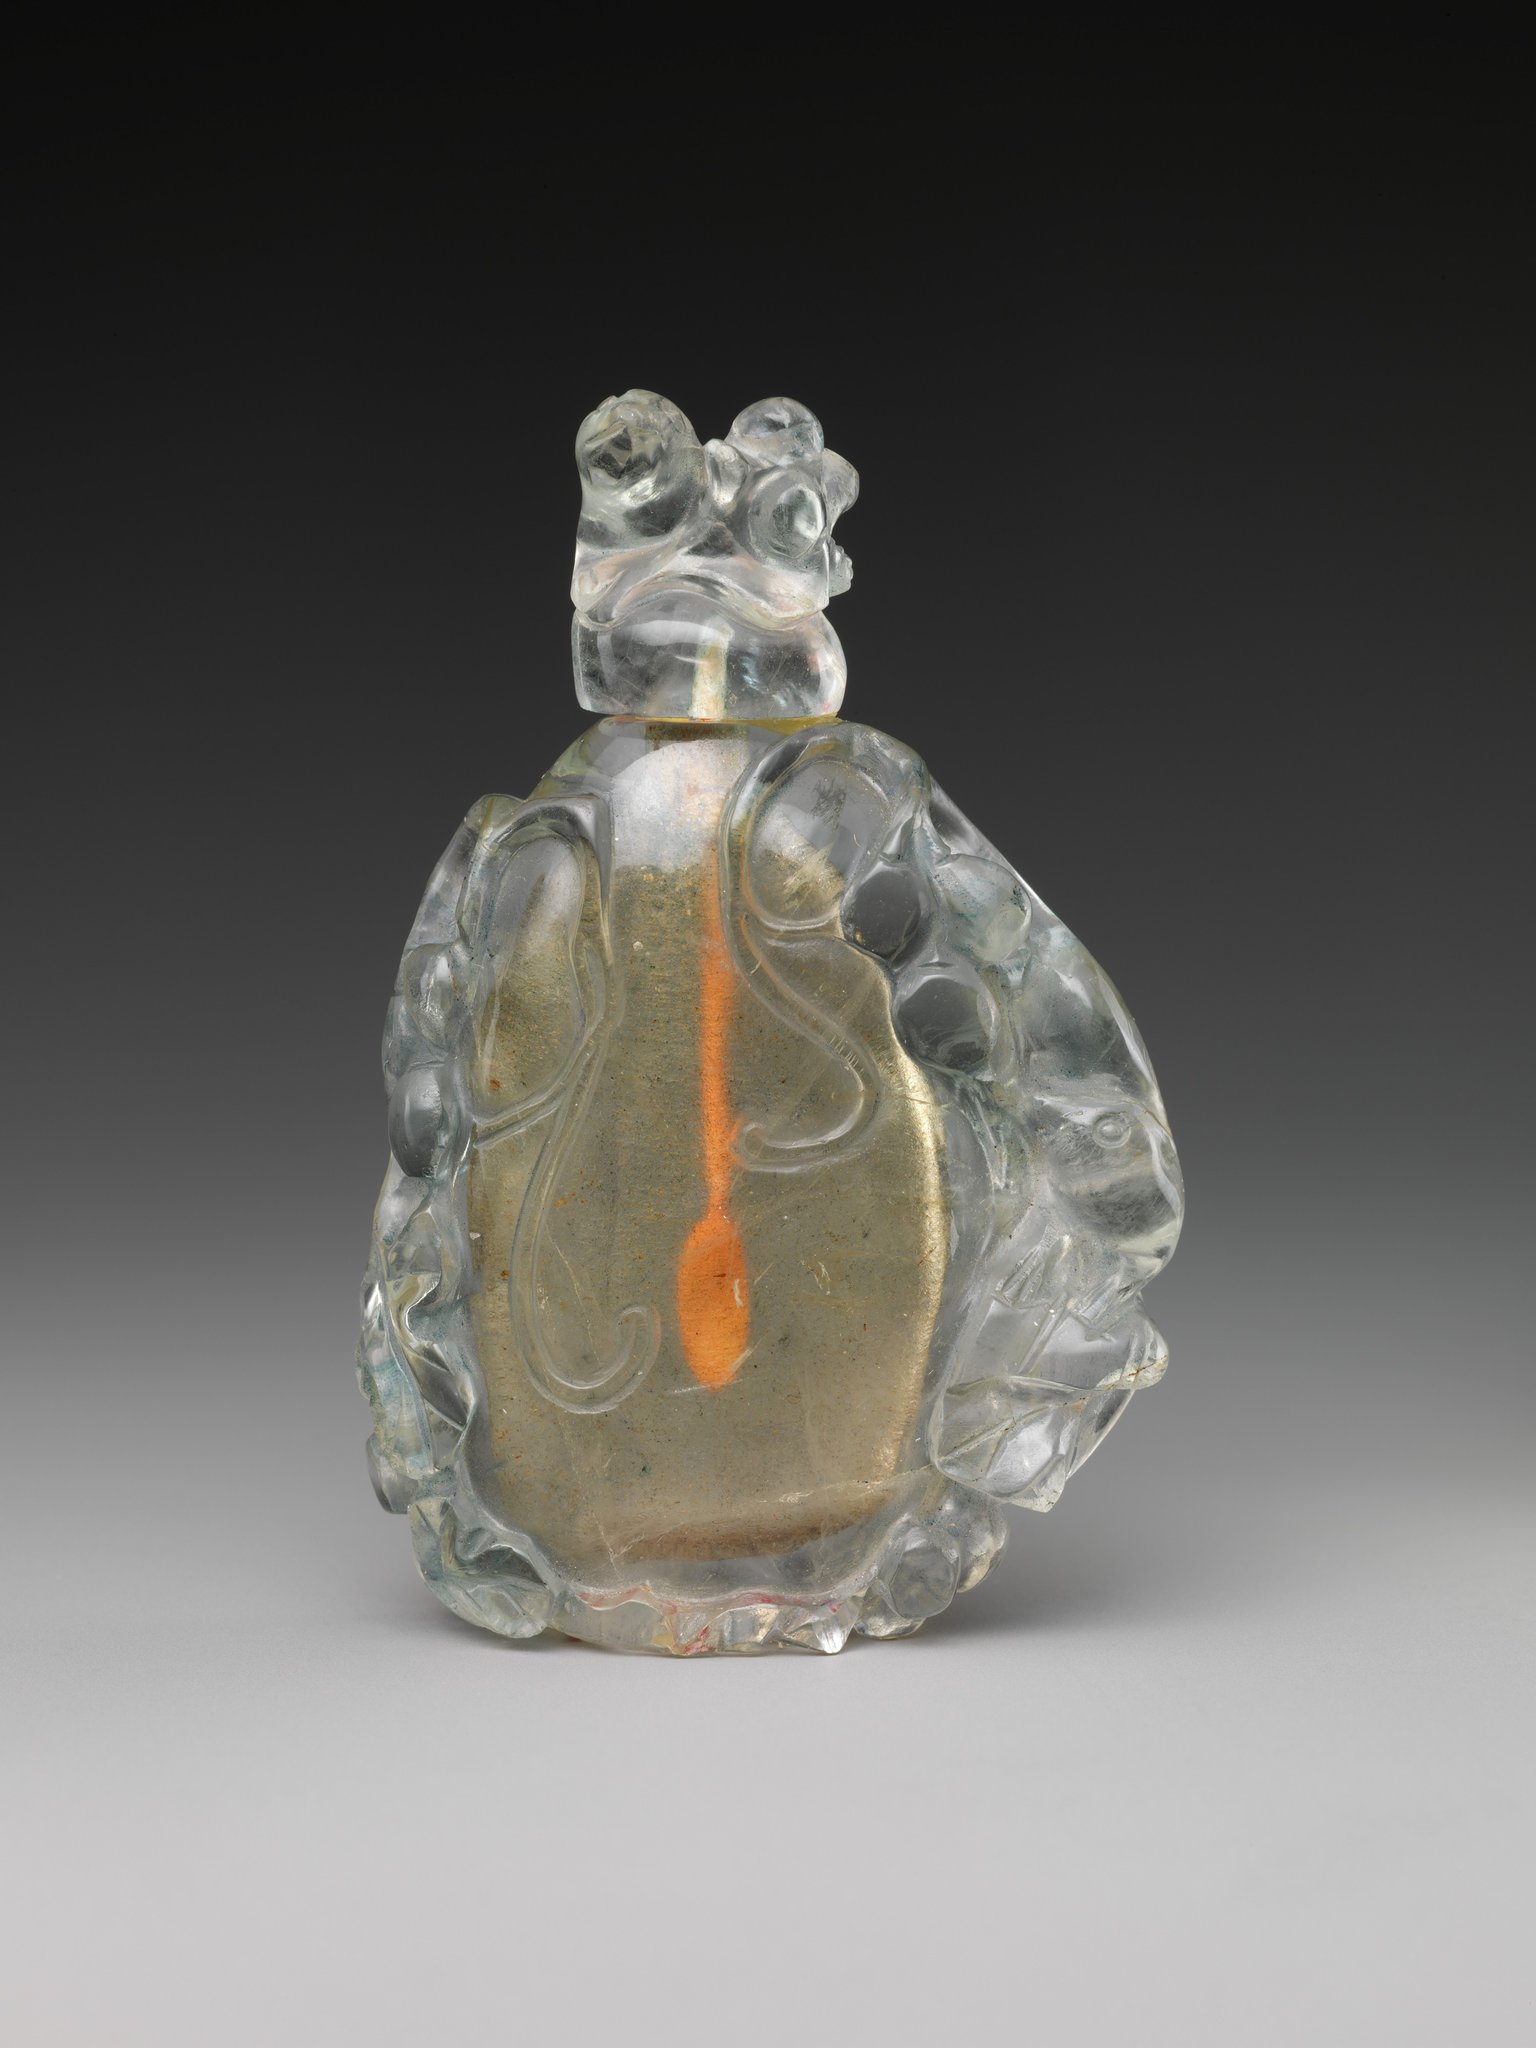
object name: snuff bottle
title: Snuff bottle with squirrel and grapes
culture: chinese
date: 1701-1800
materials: gemstone